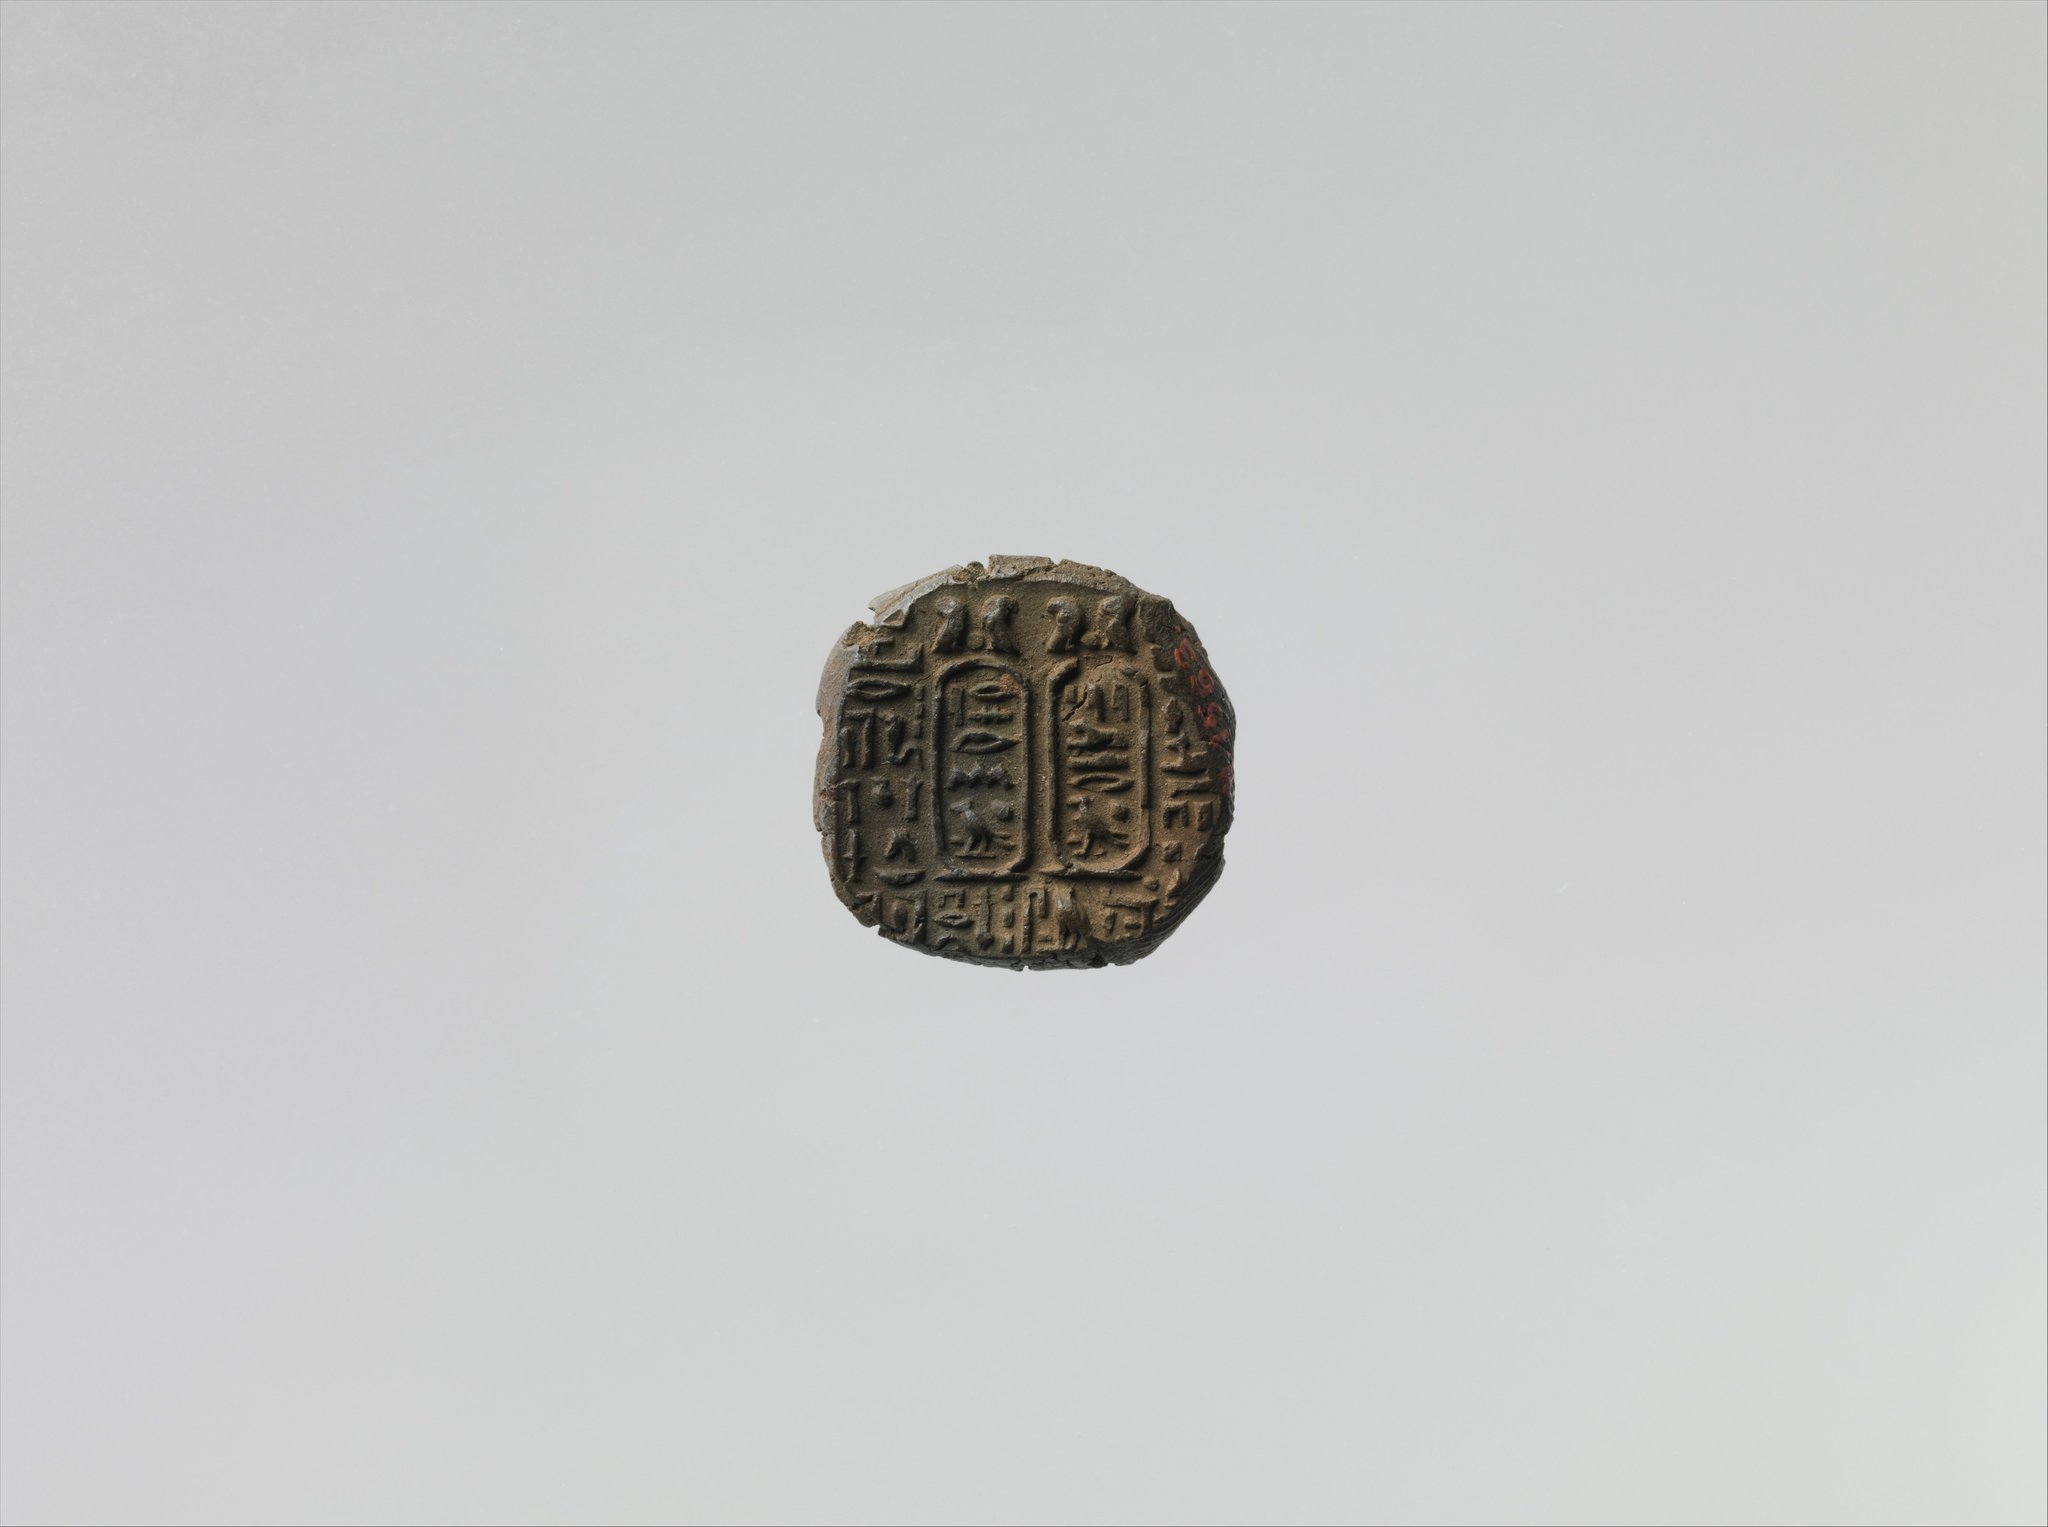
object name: seal impression, arsinoe ii and sister philotera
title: Sealing naming Nesisti, a priest in the cult of Arsinoe II and her sister Philotera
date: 210-180 BCE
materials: clay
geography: egypt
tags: hieroglyphs